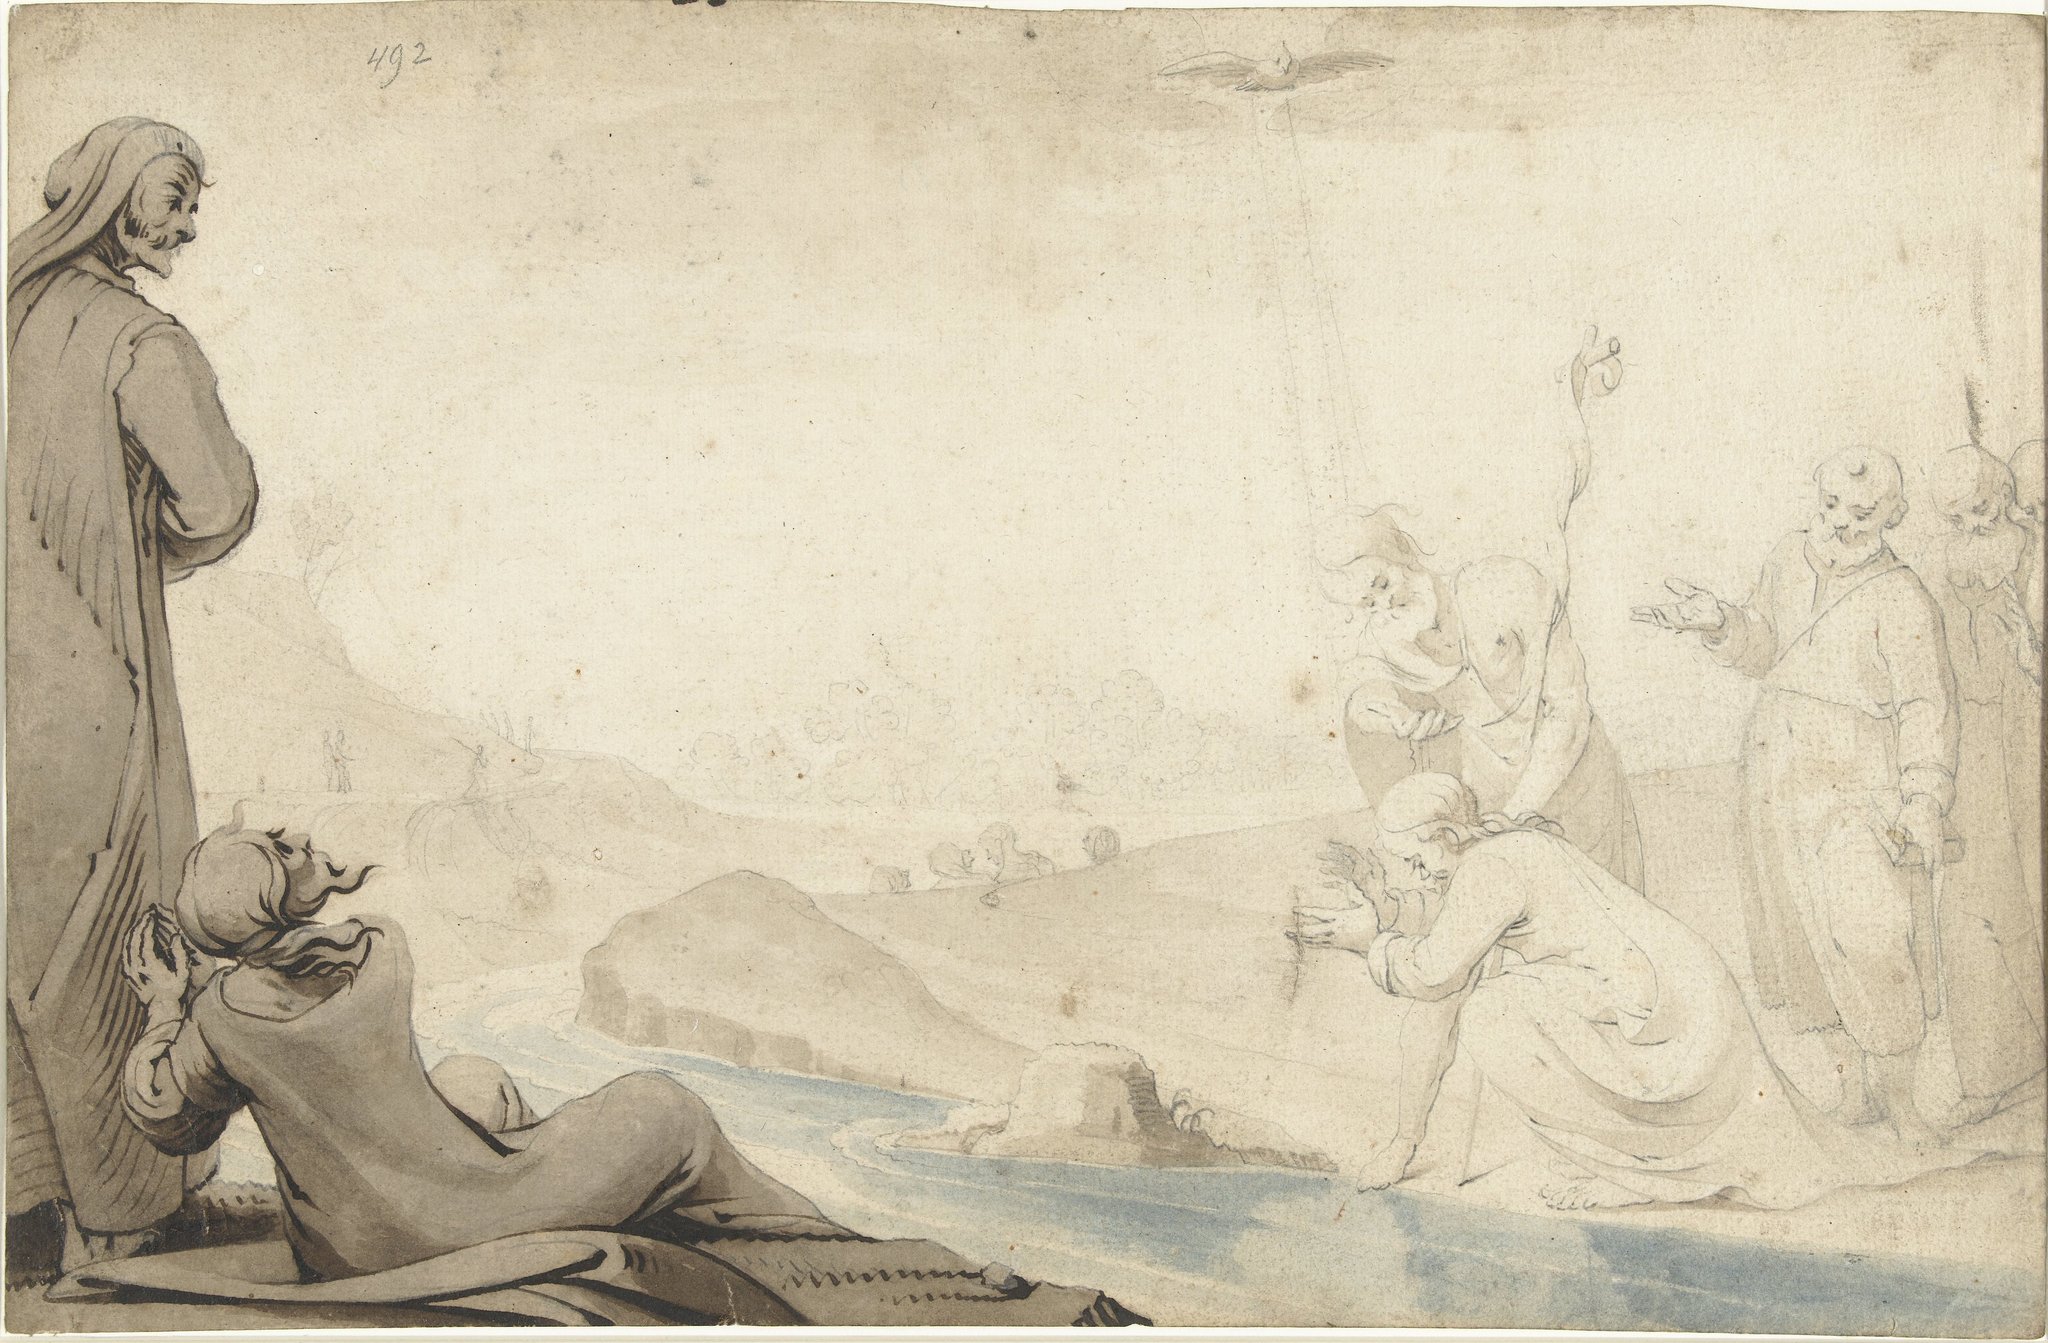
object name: watercolor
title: De doop van Christus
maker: gerard ter borch (i)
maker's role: draughtsman, print maker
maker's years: 1584-1662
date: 1617-1623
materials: ink, paper, pencil, watercolor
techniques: brush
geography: zwolle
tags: baptism of christ in the river jordan: john the baptist pouring out water on christ's head: the holy ghost descends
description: Figuur rechts, met boek, is ook gebruikt in fol. 147 van het Scrapbook (Familie-album).